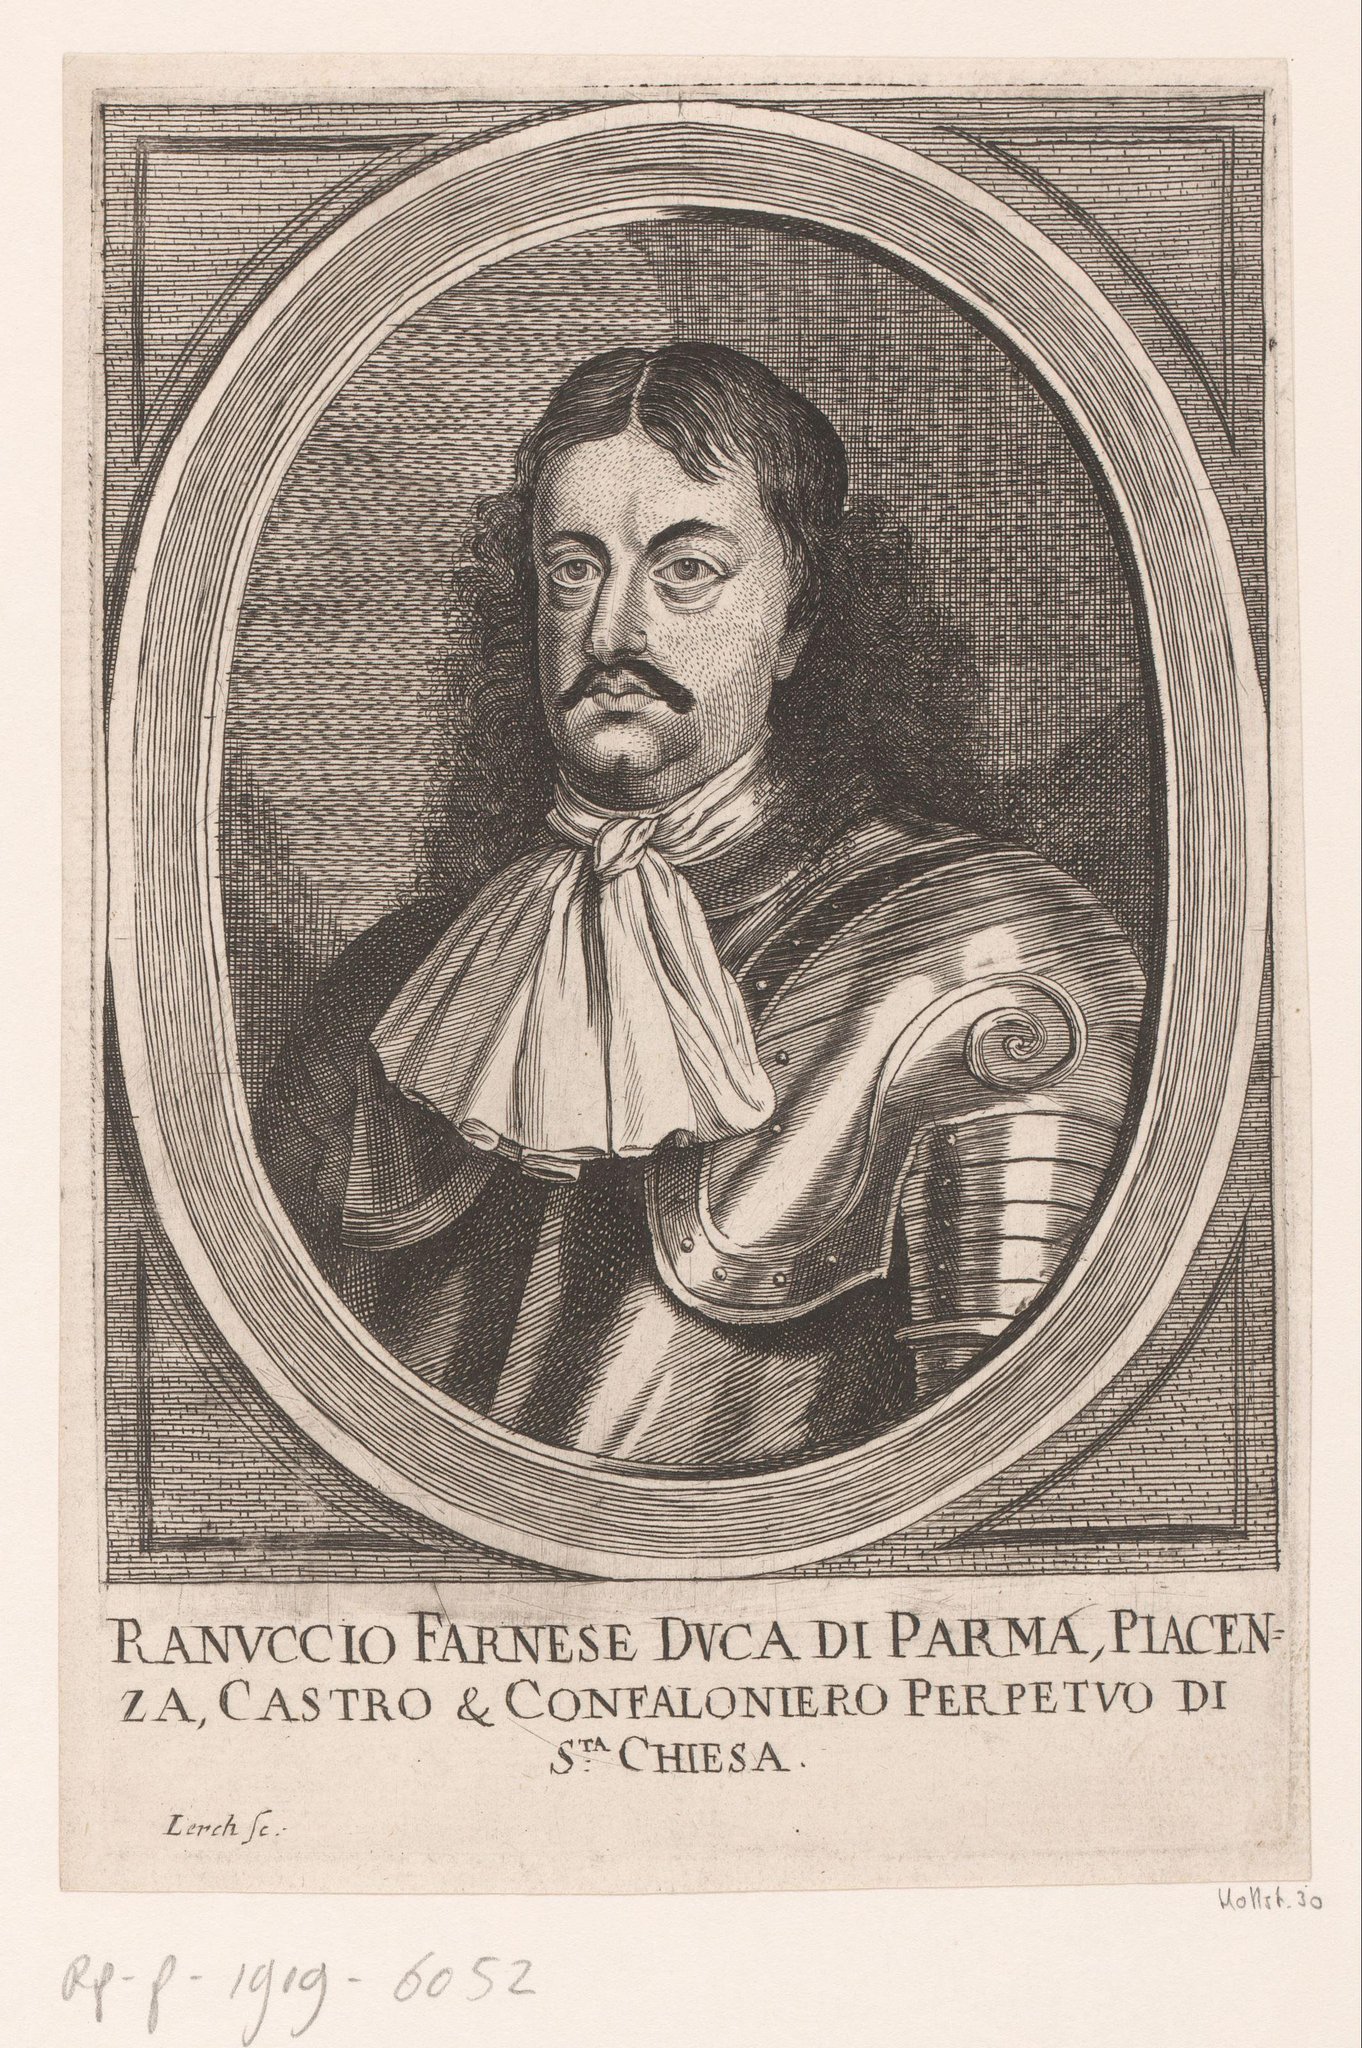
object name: print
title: Portret van Ranuccio Farnese II, hertog van Parma en Piacenza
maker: johann martin lerch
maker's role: print maker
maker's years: 1643-1693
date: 1660-1685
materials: paper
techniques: engraving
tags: historical persons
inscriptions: collector's mark: Lugt 2228